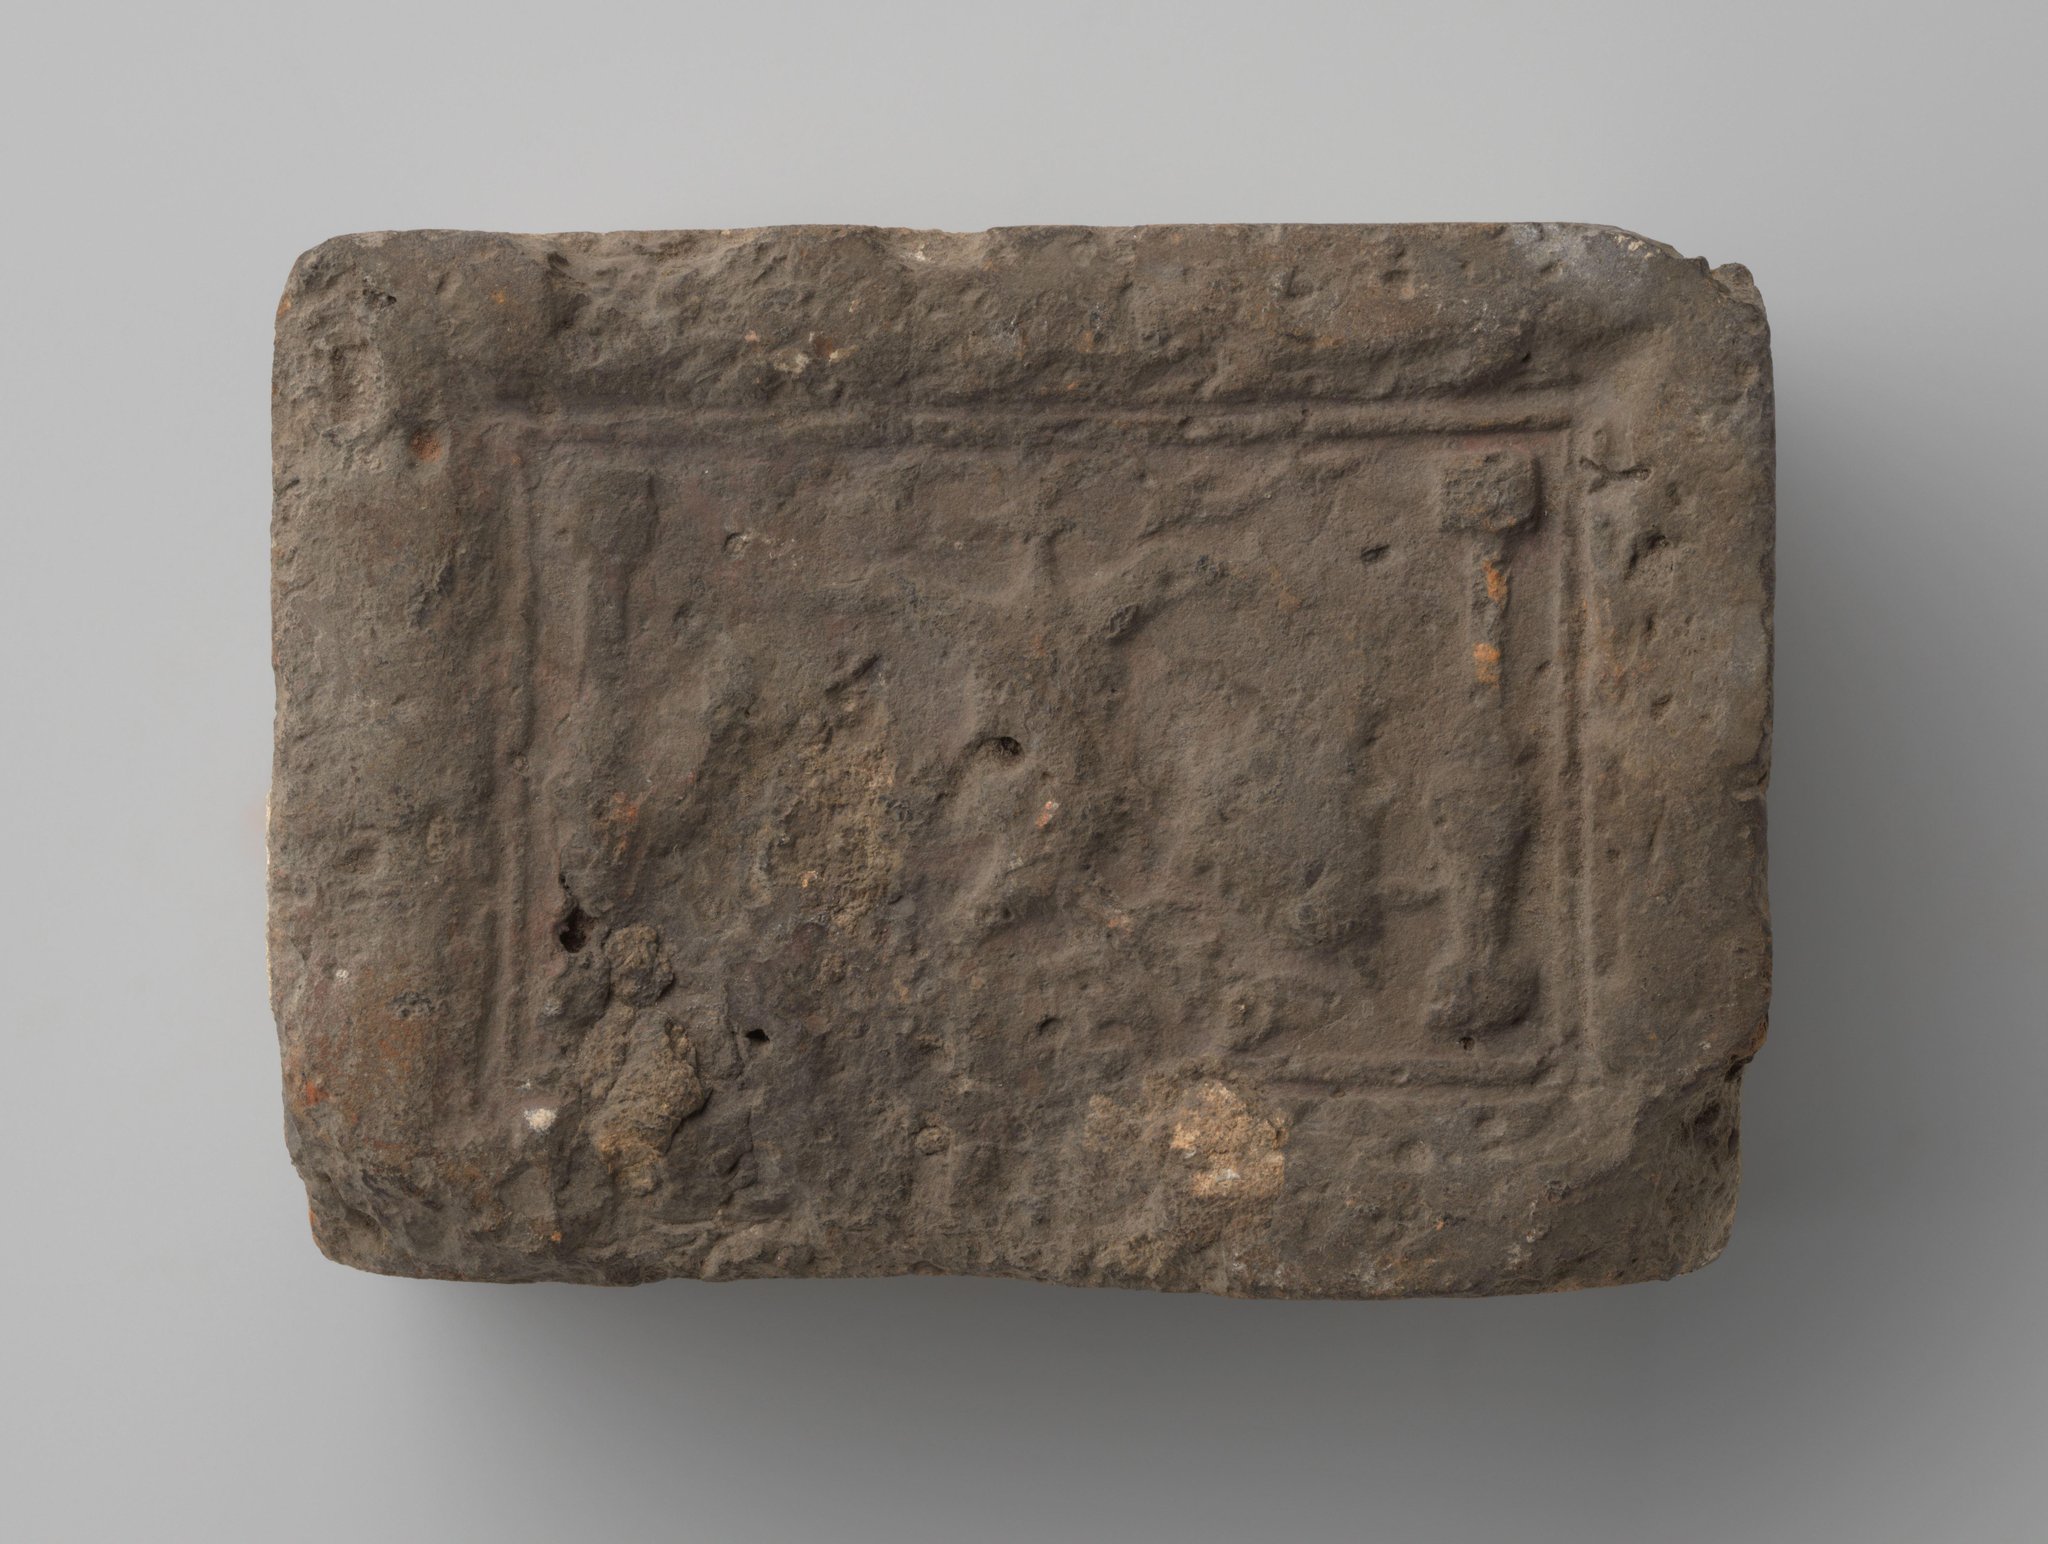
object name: hearthstone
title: Haardsteen met voorstelling van de tweekoppige adelaar tussen de zuilen van Hercules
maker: Anonymous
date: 1550-1600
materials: earthenware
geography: southern netherlands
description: Haardsteen met voorstelling van de tweekoppige adelaar tussen de zuilen van Hercules.